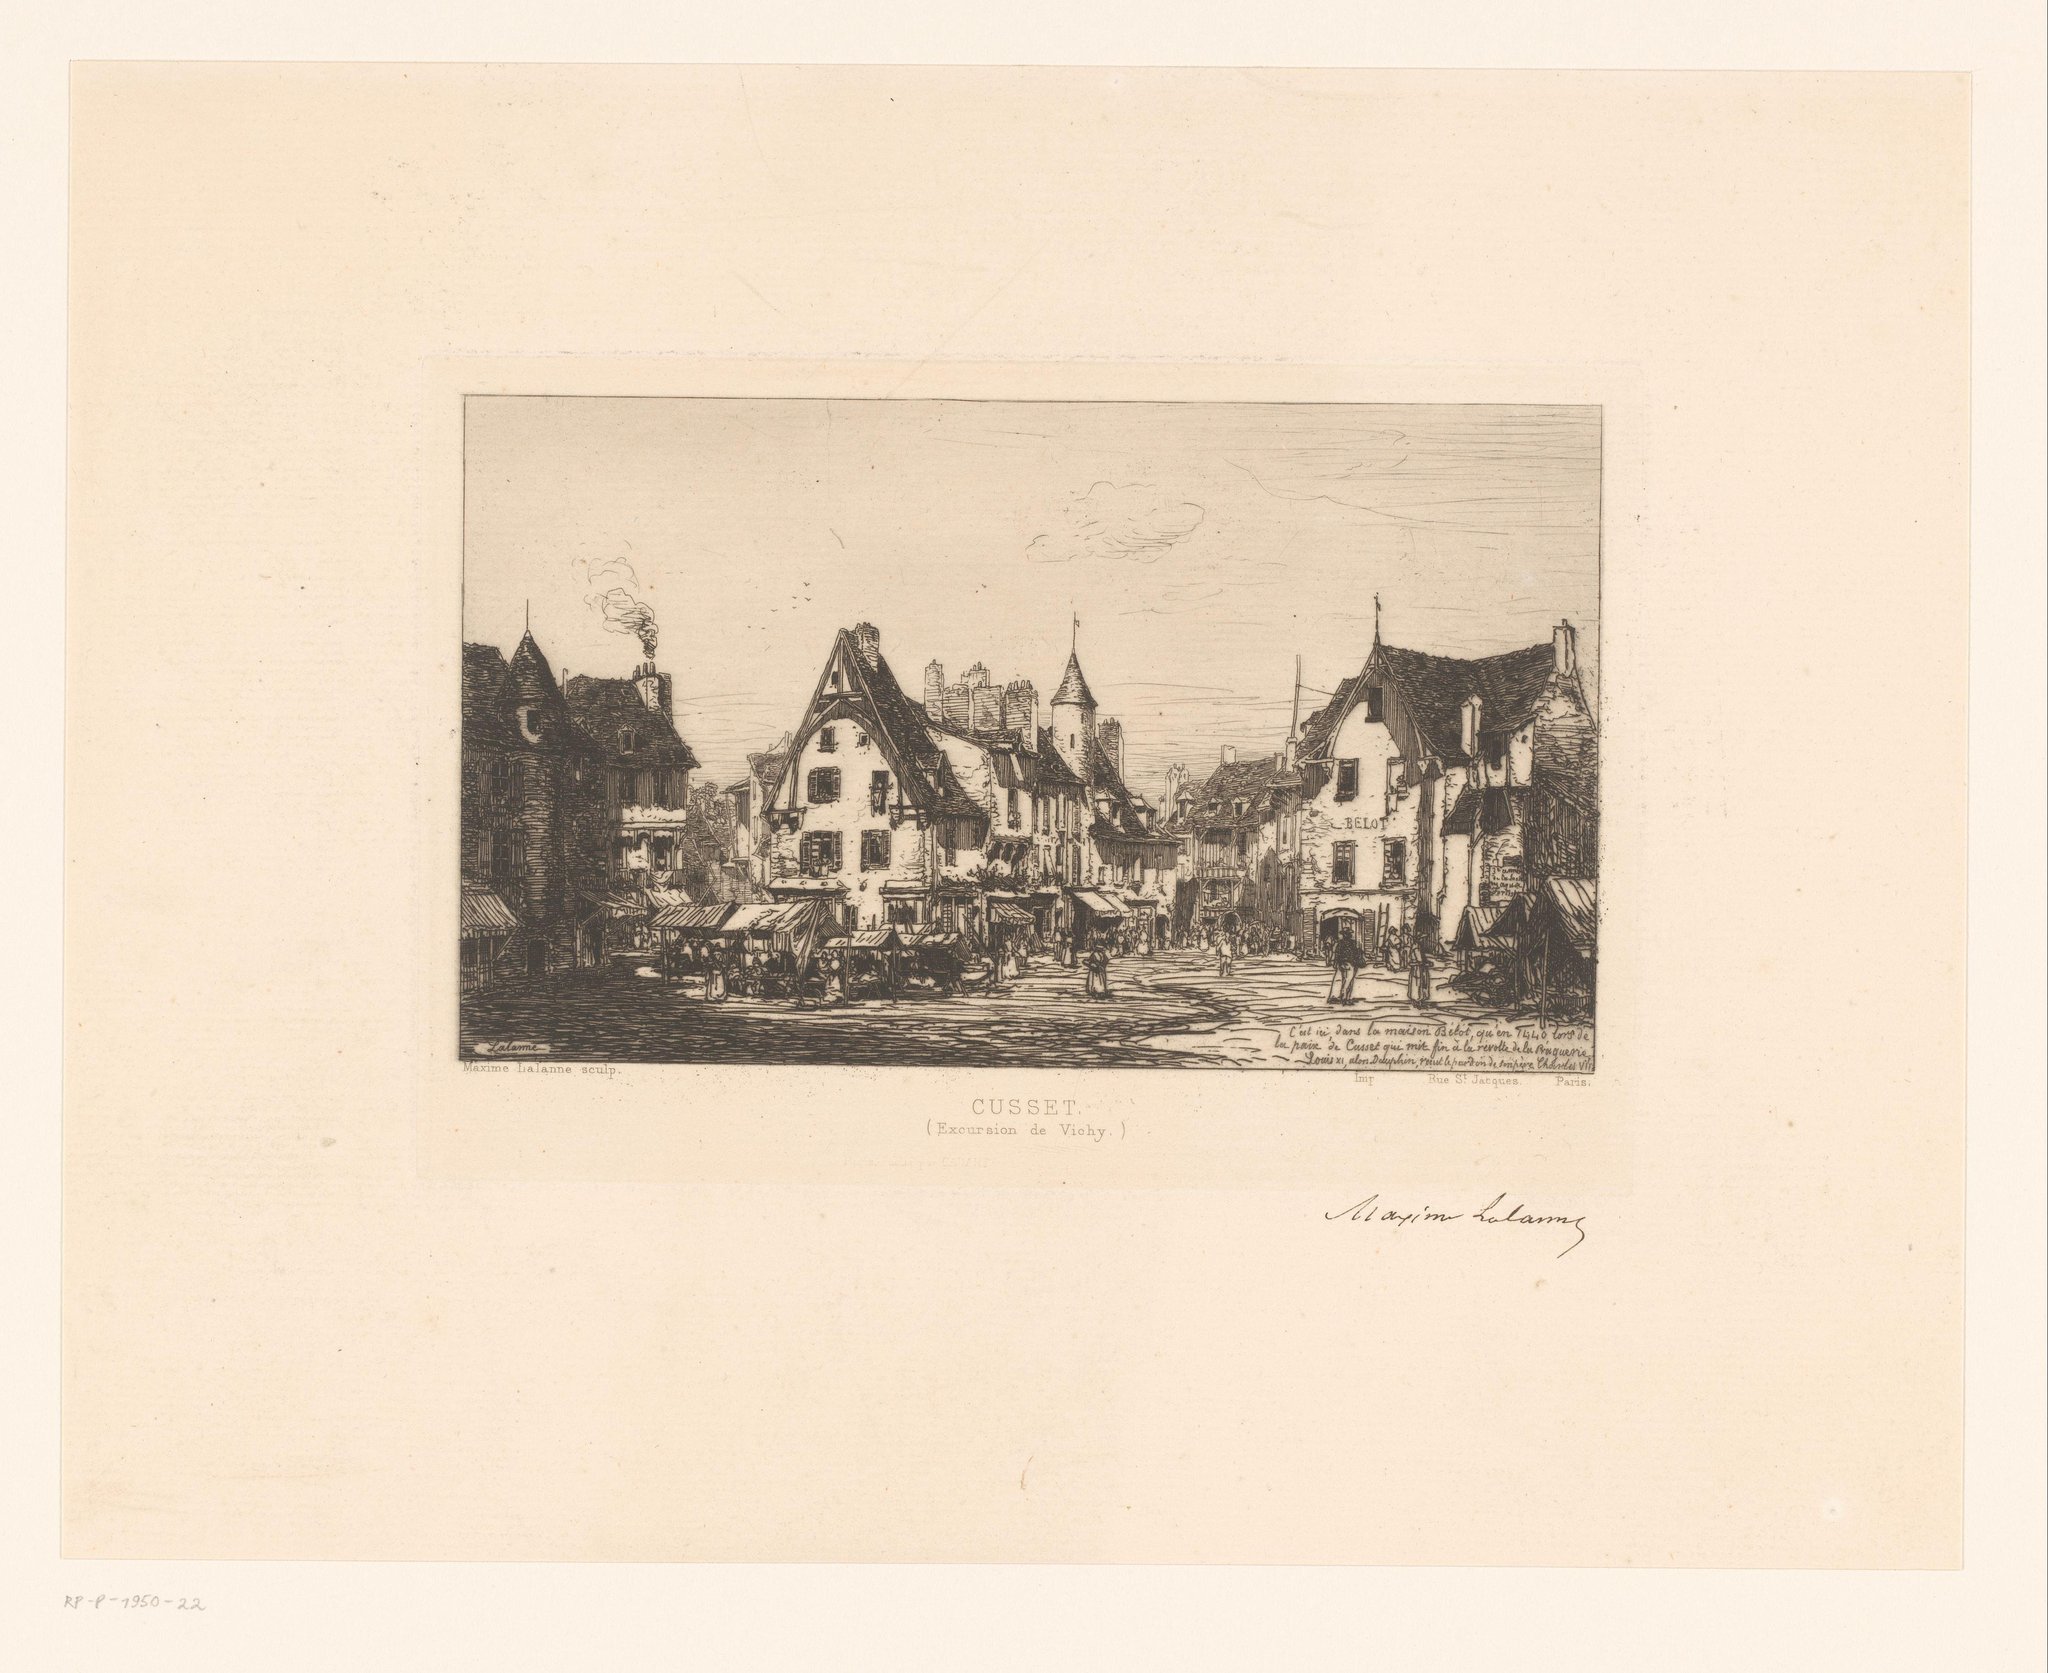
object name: print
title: Gezicht op Cusset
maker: maxime françois antoine lalanne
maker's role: draughtsman, print maker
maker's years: 1827-1886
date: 1865-1866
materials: paper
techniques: drypoint, etching, intaglio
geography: paris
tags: city-view in general; 'veduta'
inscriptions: collector's mark: Lugt 2228